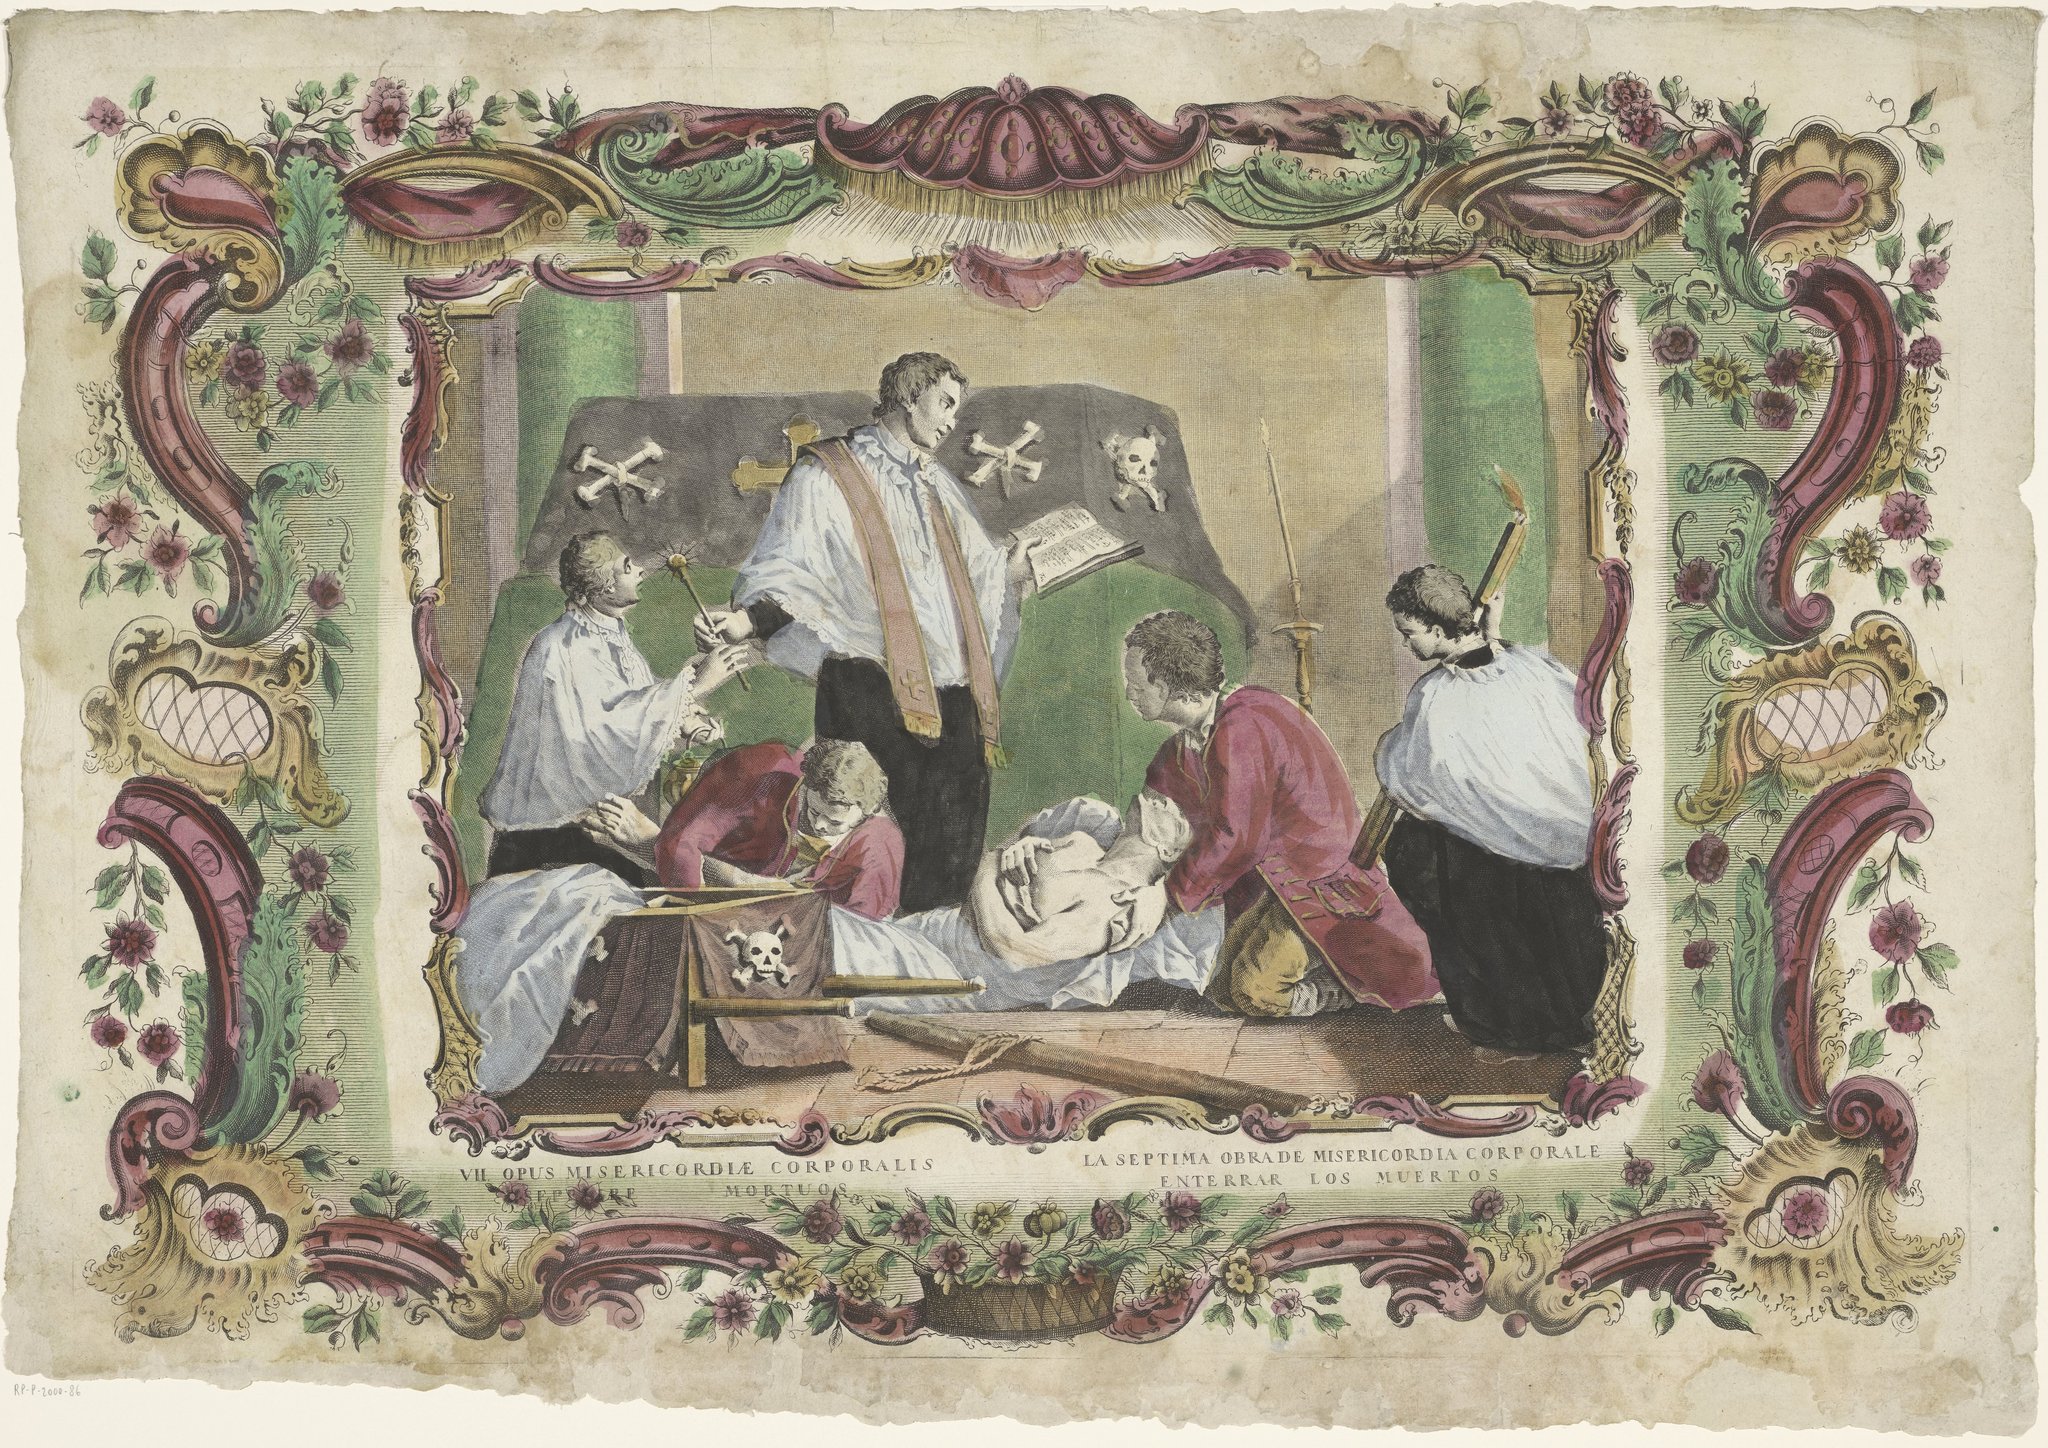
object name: print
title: De doden begraven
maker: giovanni volpato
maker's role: ceramicist, print maker, printer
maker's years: 1735-1803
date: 1700-1799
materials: paper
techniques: colour, engraving, etching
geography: bassano del grappa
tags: ornaments ~ art, burying the dead, 'mortuus sepellitur' ~ one of the (seven) acts of mercy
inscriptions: collector's mark: Lugt 2760, collector's mark: Lugt 2228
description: Uitbeelding van één van de spirituele werken van barmhartigheid: het gebraven van de doden. Een priester leest een gebed voor terwijl een dode in zijn kist wordt gelegd door twee mannen. Links en rechts een jonge misdienaar. Achter de priester een sarcofaag waaroverheen een doodskleed. Titel onder de voorstelling. De scène is gevat in een ornamentrand.